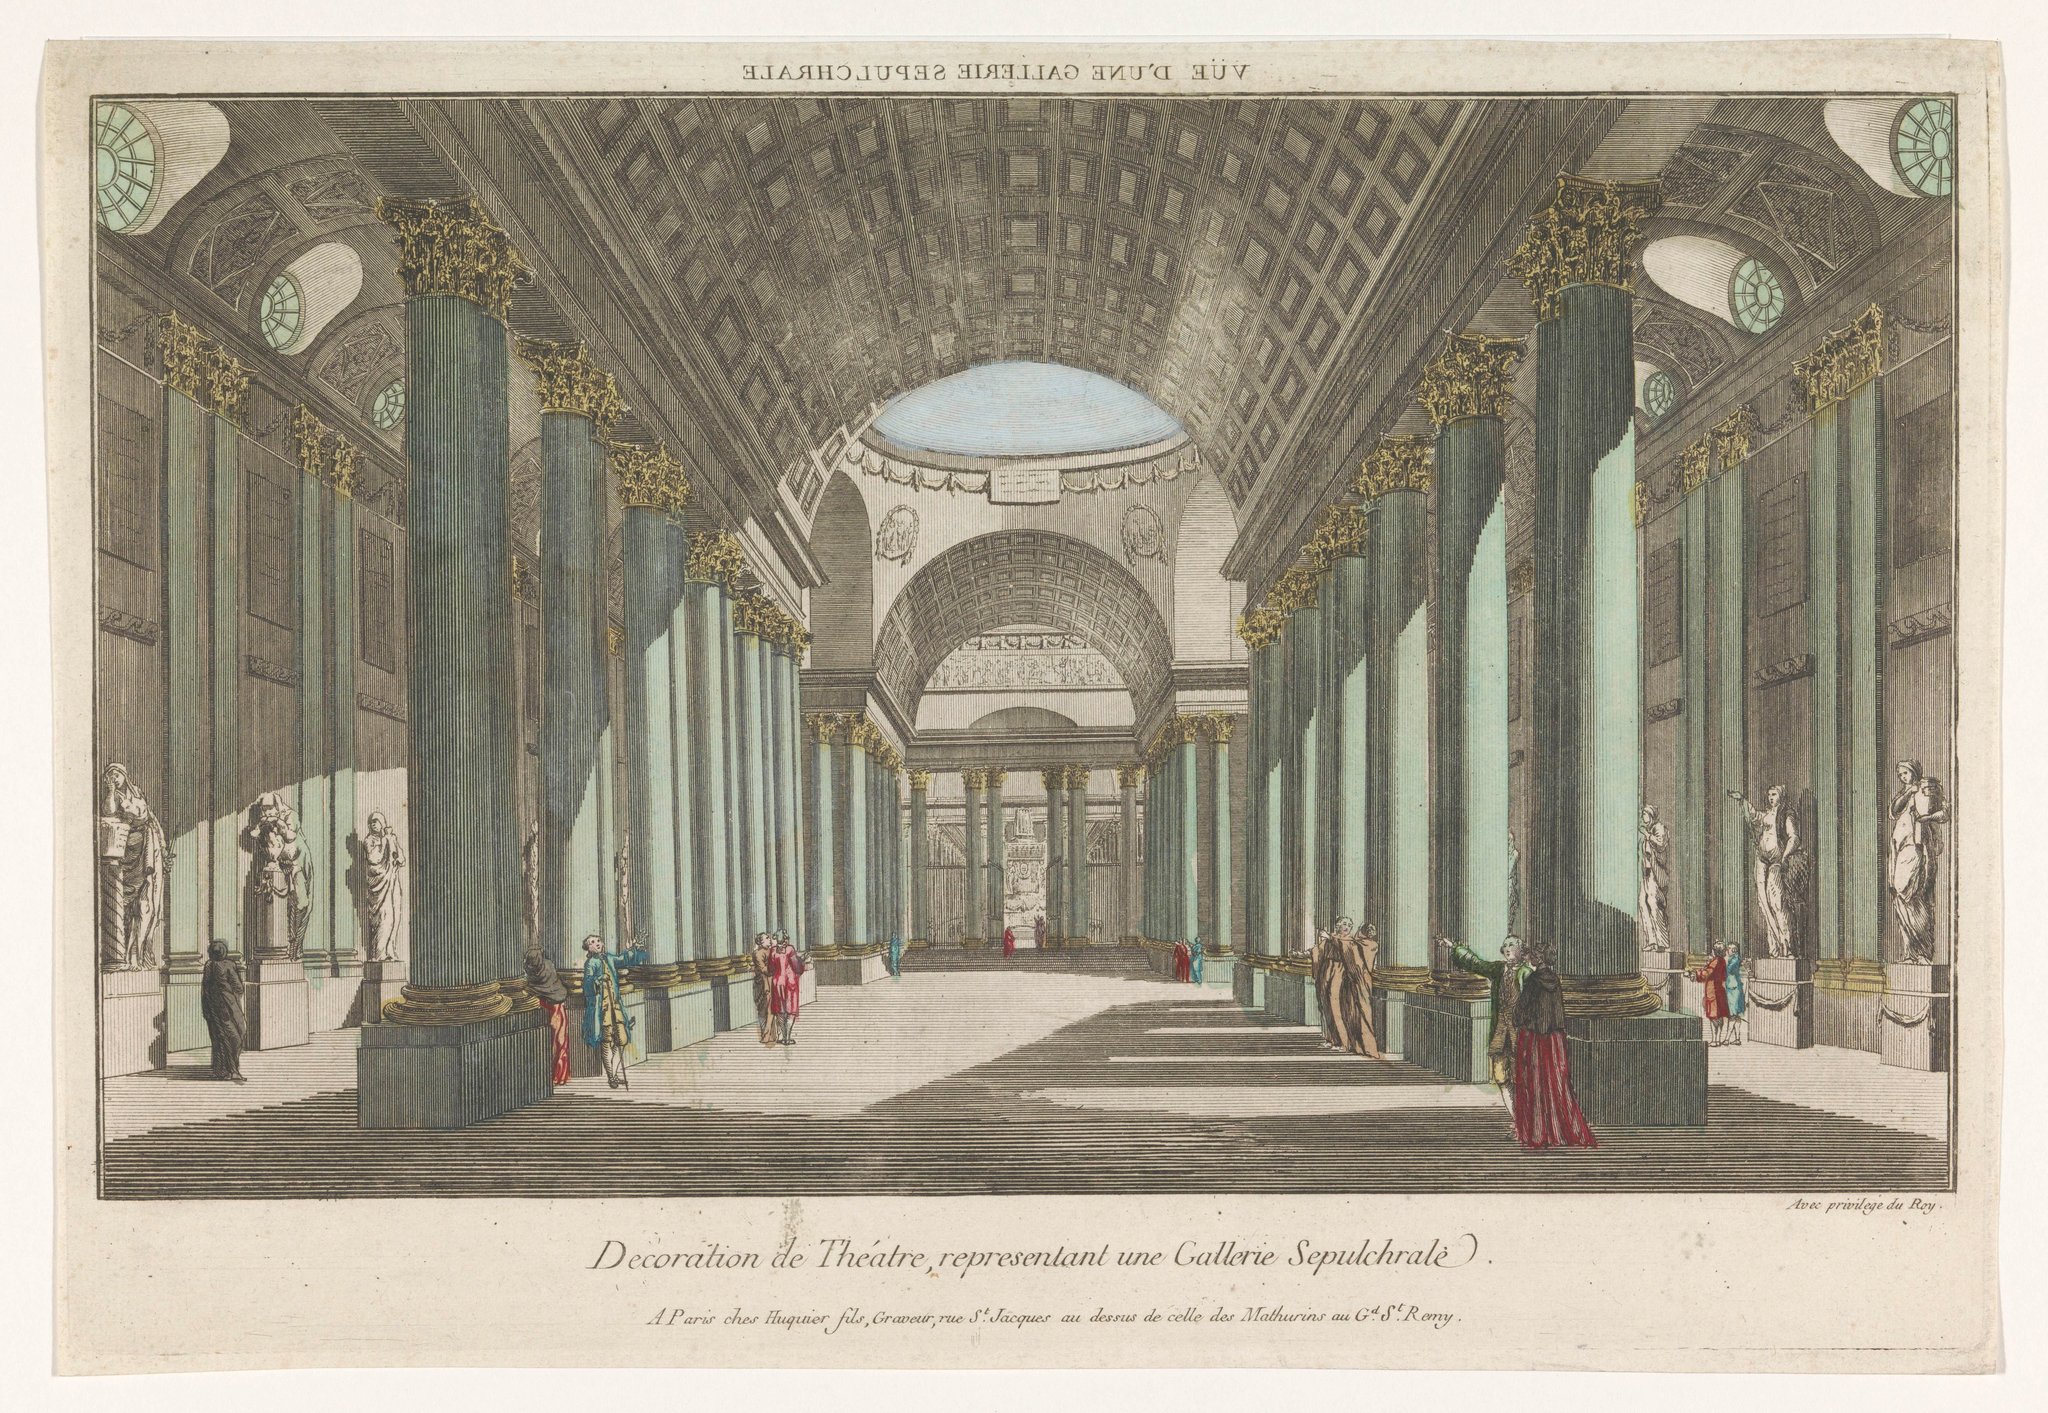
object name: print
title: Gezicht op een galerie met sepulchrale beelden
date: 1735-1805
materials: paper, watercolor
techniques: brush, etching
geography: paris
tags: gallery of sculptures, grave, tomb and other grave-forms and grave-markers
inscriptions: watermark, collector's mark: Lugt 2233